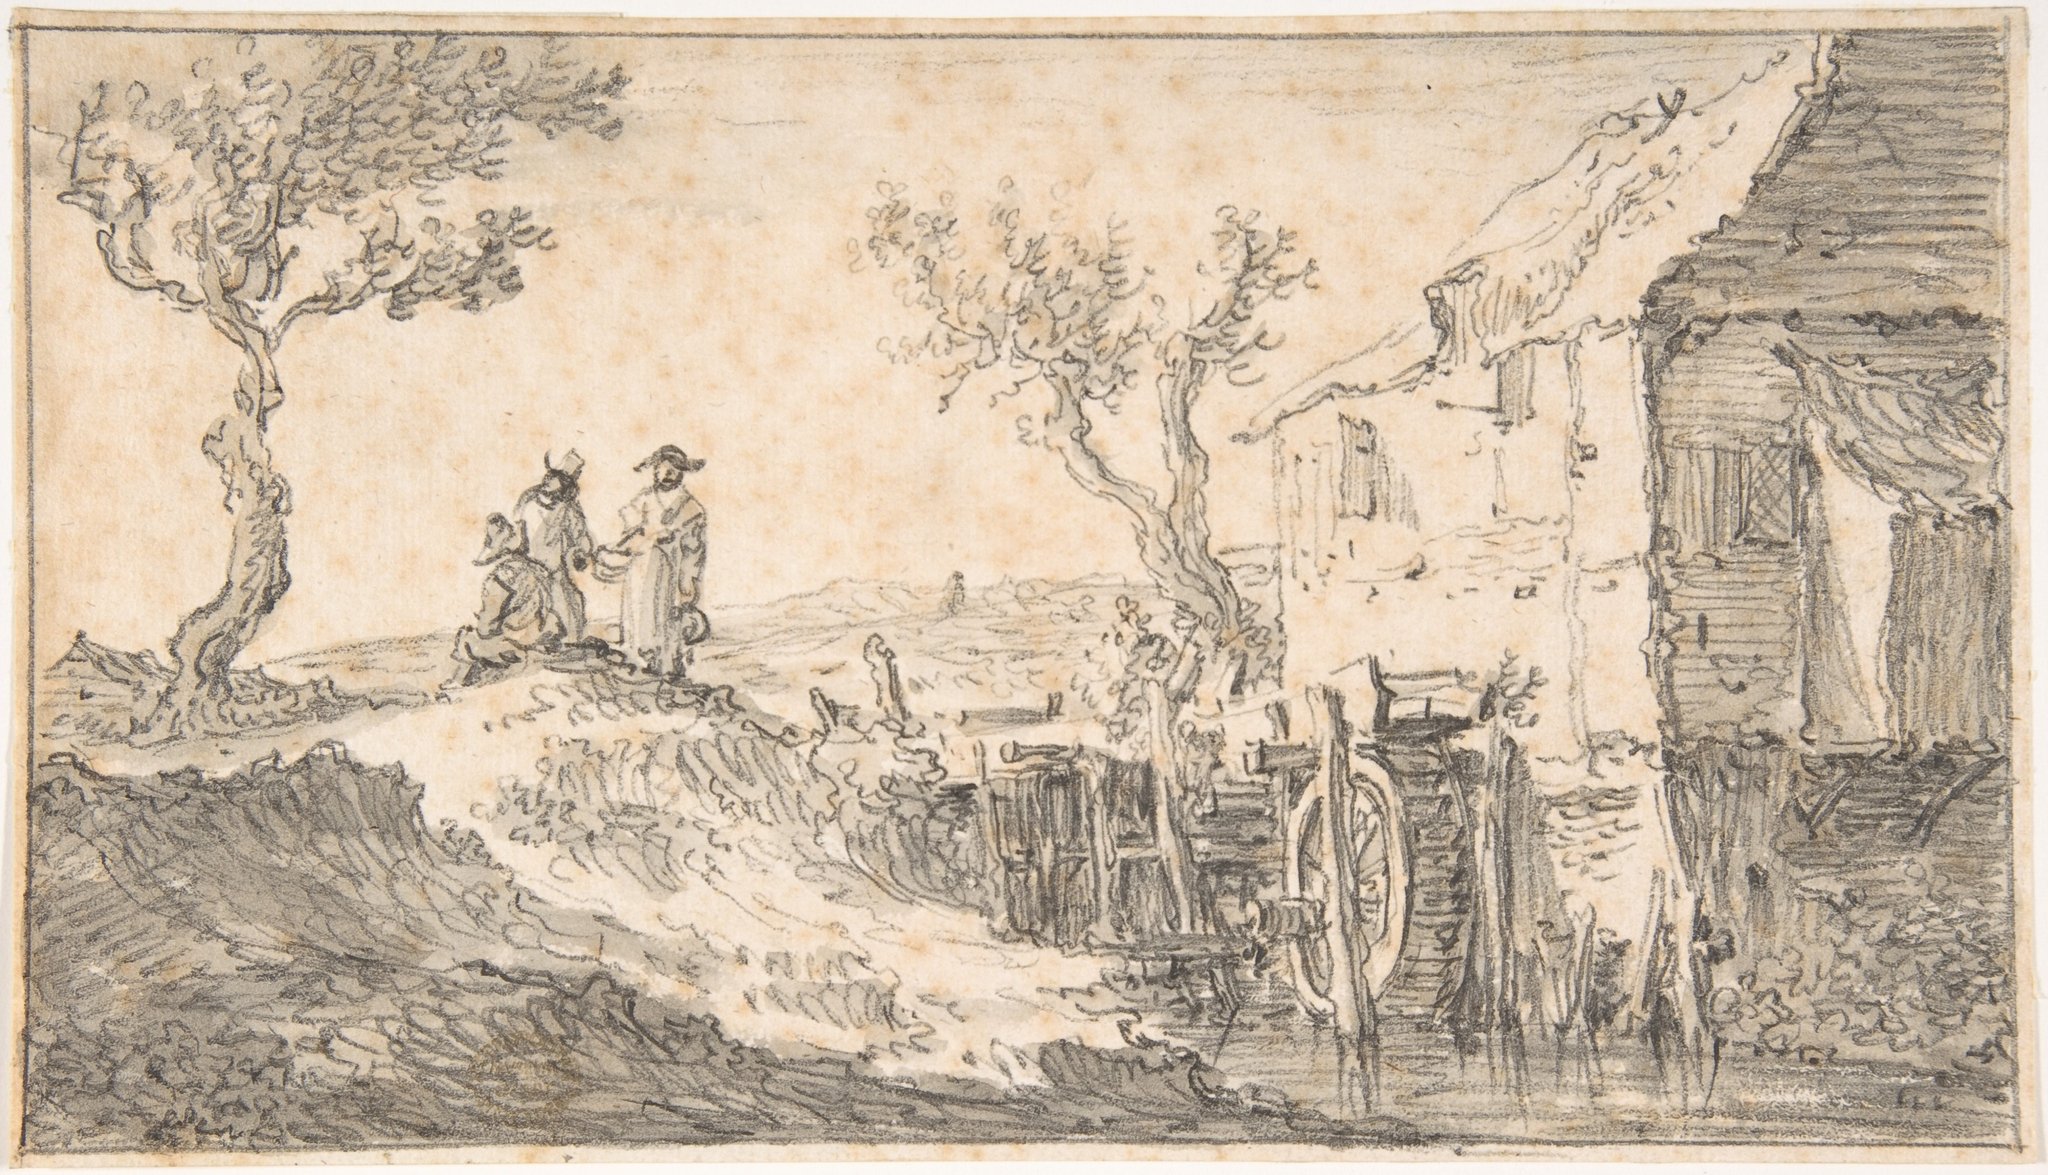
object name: drawing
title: The Water Mill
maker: jan van goyen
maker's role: artist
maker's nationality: dutch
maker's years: 1596-1656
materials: chalk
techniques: wash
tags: watermills,men,trees